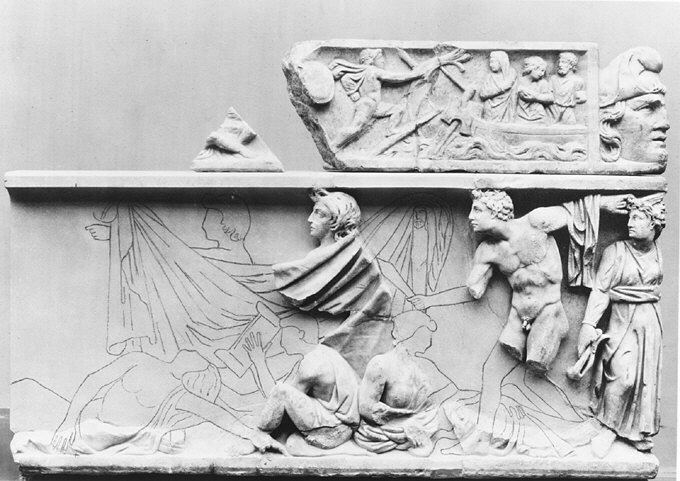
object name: sarcophagus fragment, orestes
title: Fragmentary marble sarcophagus with scenes from the Oresteia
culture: roman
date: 134-166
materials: marble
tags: male nudes,women,boats